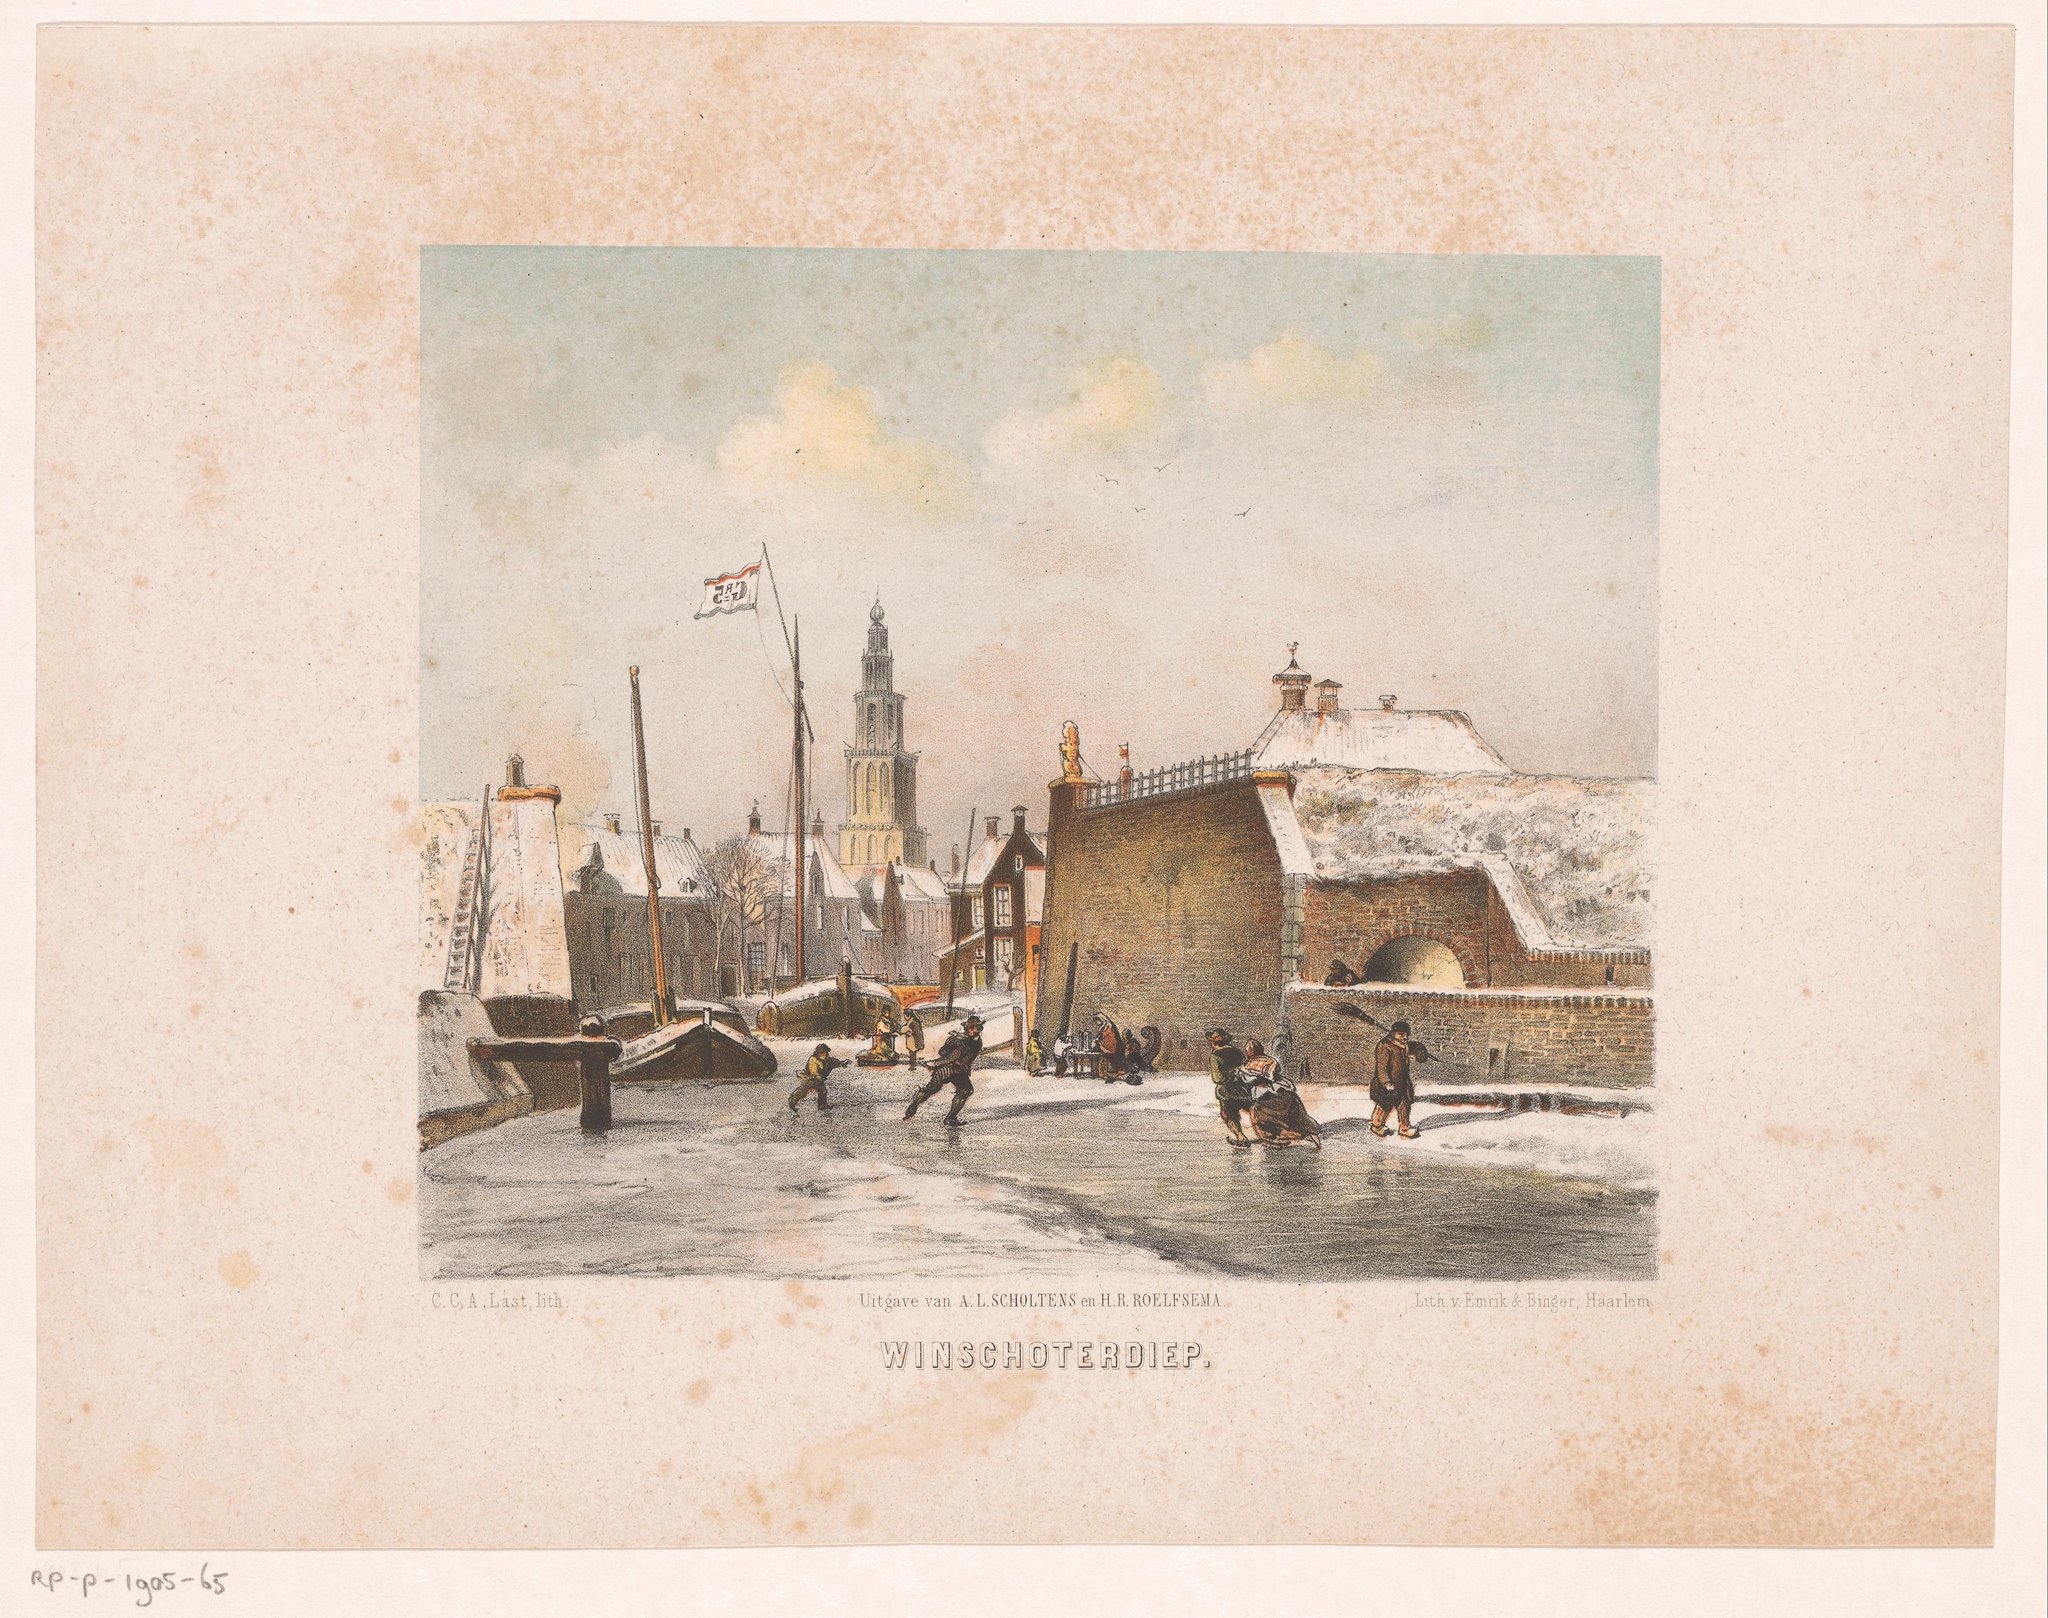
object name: print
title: Winschoterdiep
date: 1857-1869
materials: paper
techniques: lithograph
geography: groningen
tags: winter landscape; landscape symbolizing winter (the four seasons of the year), skates (winter sports)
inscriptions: collector's mark: Lugt 2228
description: Behoort tot een serie van, in ieder geval, twaalf prenten over Groningen. Zie RP-P-1905-63 t/m RP-P-1905-74.